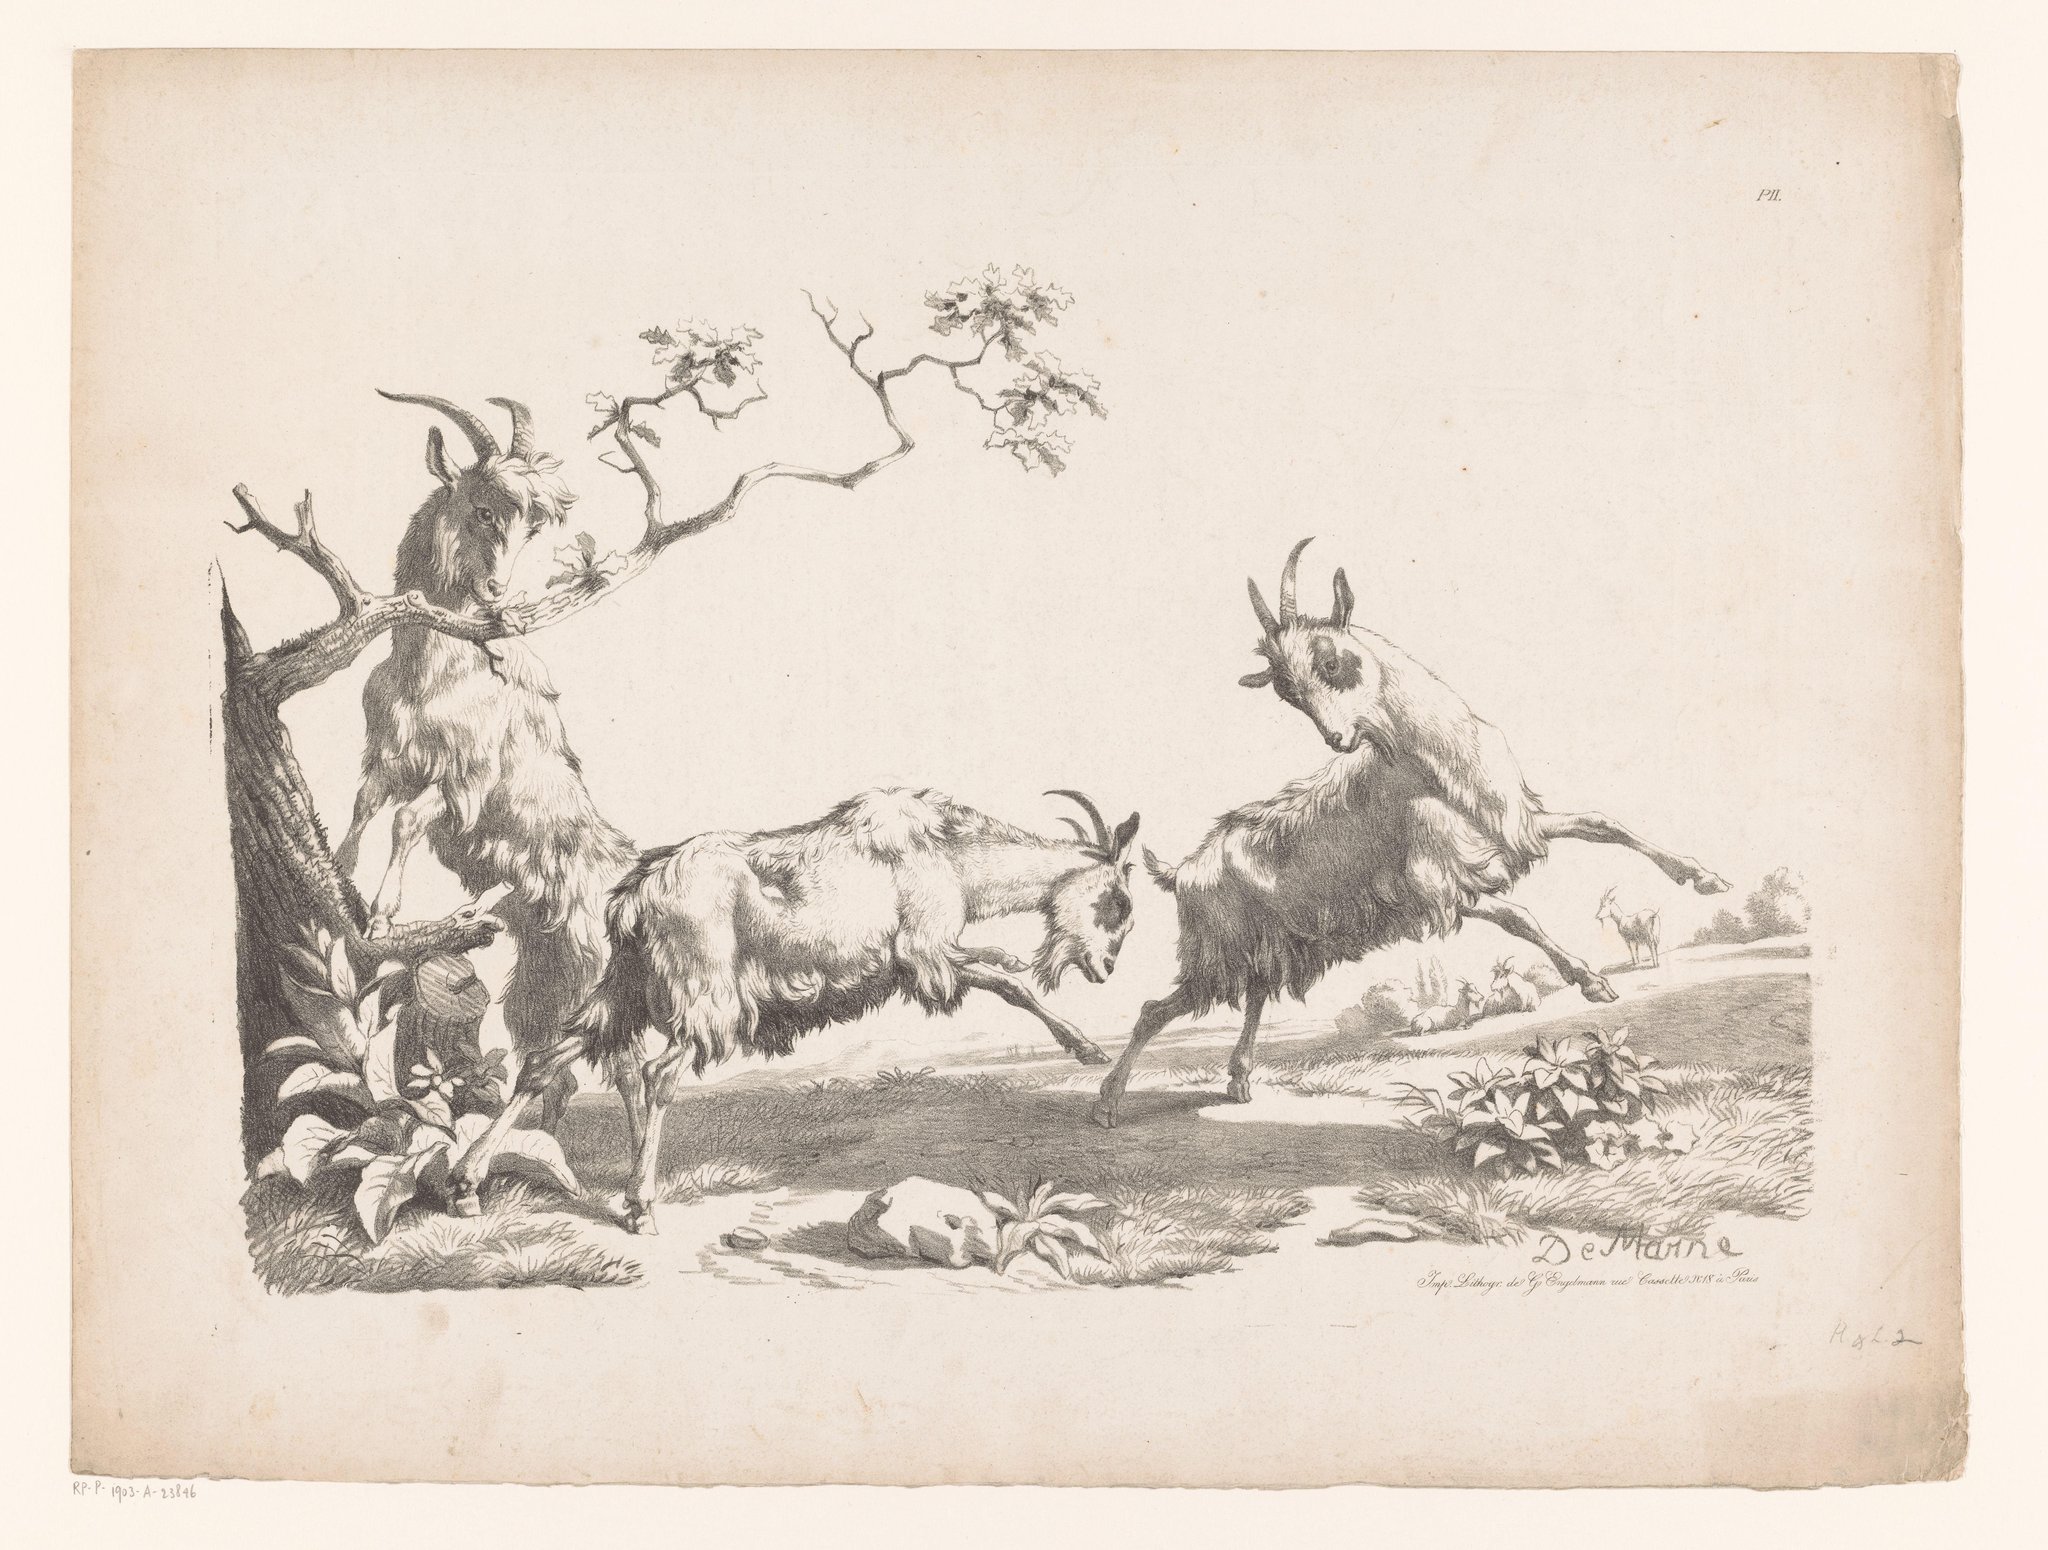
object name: print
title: Studies van geiten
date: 1816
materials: paper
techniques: lithograph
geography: paris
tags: landscapes, goat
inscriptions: collector's mark: Lugt 2228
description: Prent uit de serie: Demarne, Jean Louis. Cours complet d'études du dessin: animaux I. Études de chevres. Parijs: Engelmann, 1816.